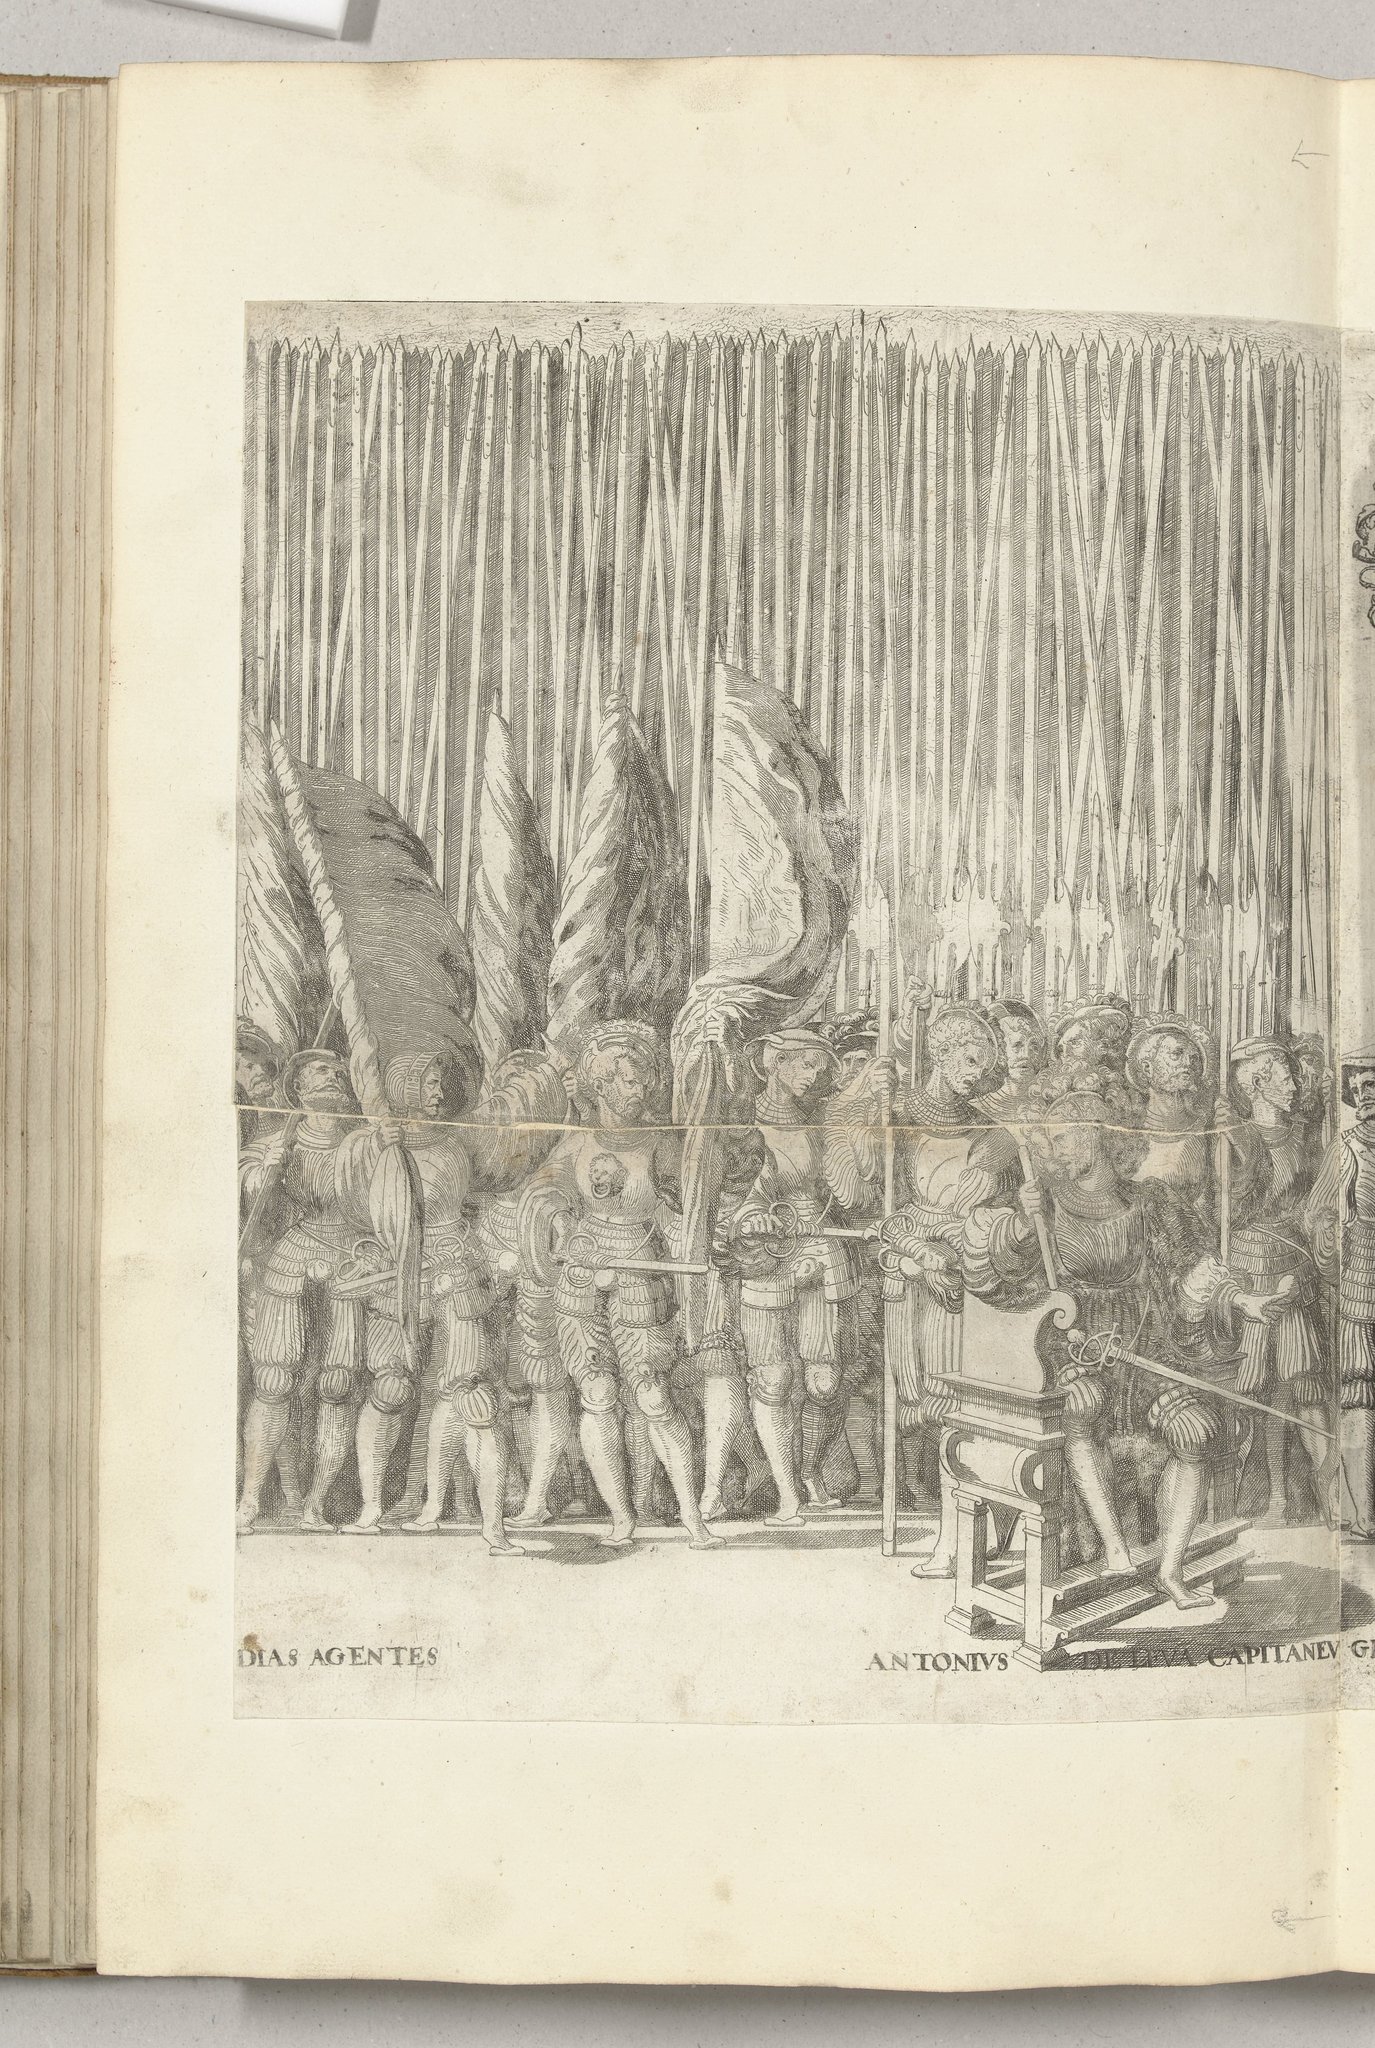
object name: print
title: Optocht van Karel V met de paus te Bologna na zijn kroning to keizer, 1530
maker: nicolaas hogenberg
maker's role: draughtsman, painter, print maker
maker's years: 1500-1539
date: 1530-1536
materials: paper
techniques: etching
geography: mechelen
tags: ghent, charles v (holy roman emperor and king of spain), festivities (+ parade, pageant, cavalcade ~ festive activities)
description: Prent in het album waarin zijn ingeplakt de 40 platen die achterelkaar samen het fries vormen van de optocht van Karel V met de paus Clemens VII te Bologna na zijn kroning tot keizer, 24 februari 1530.